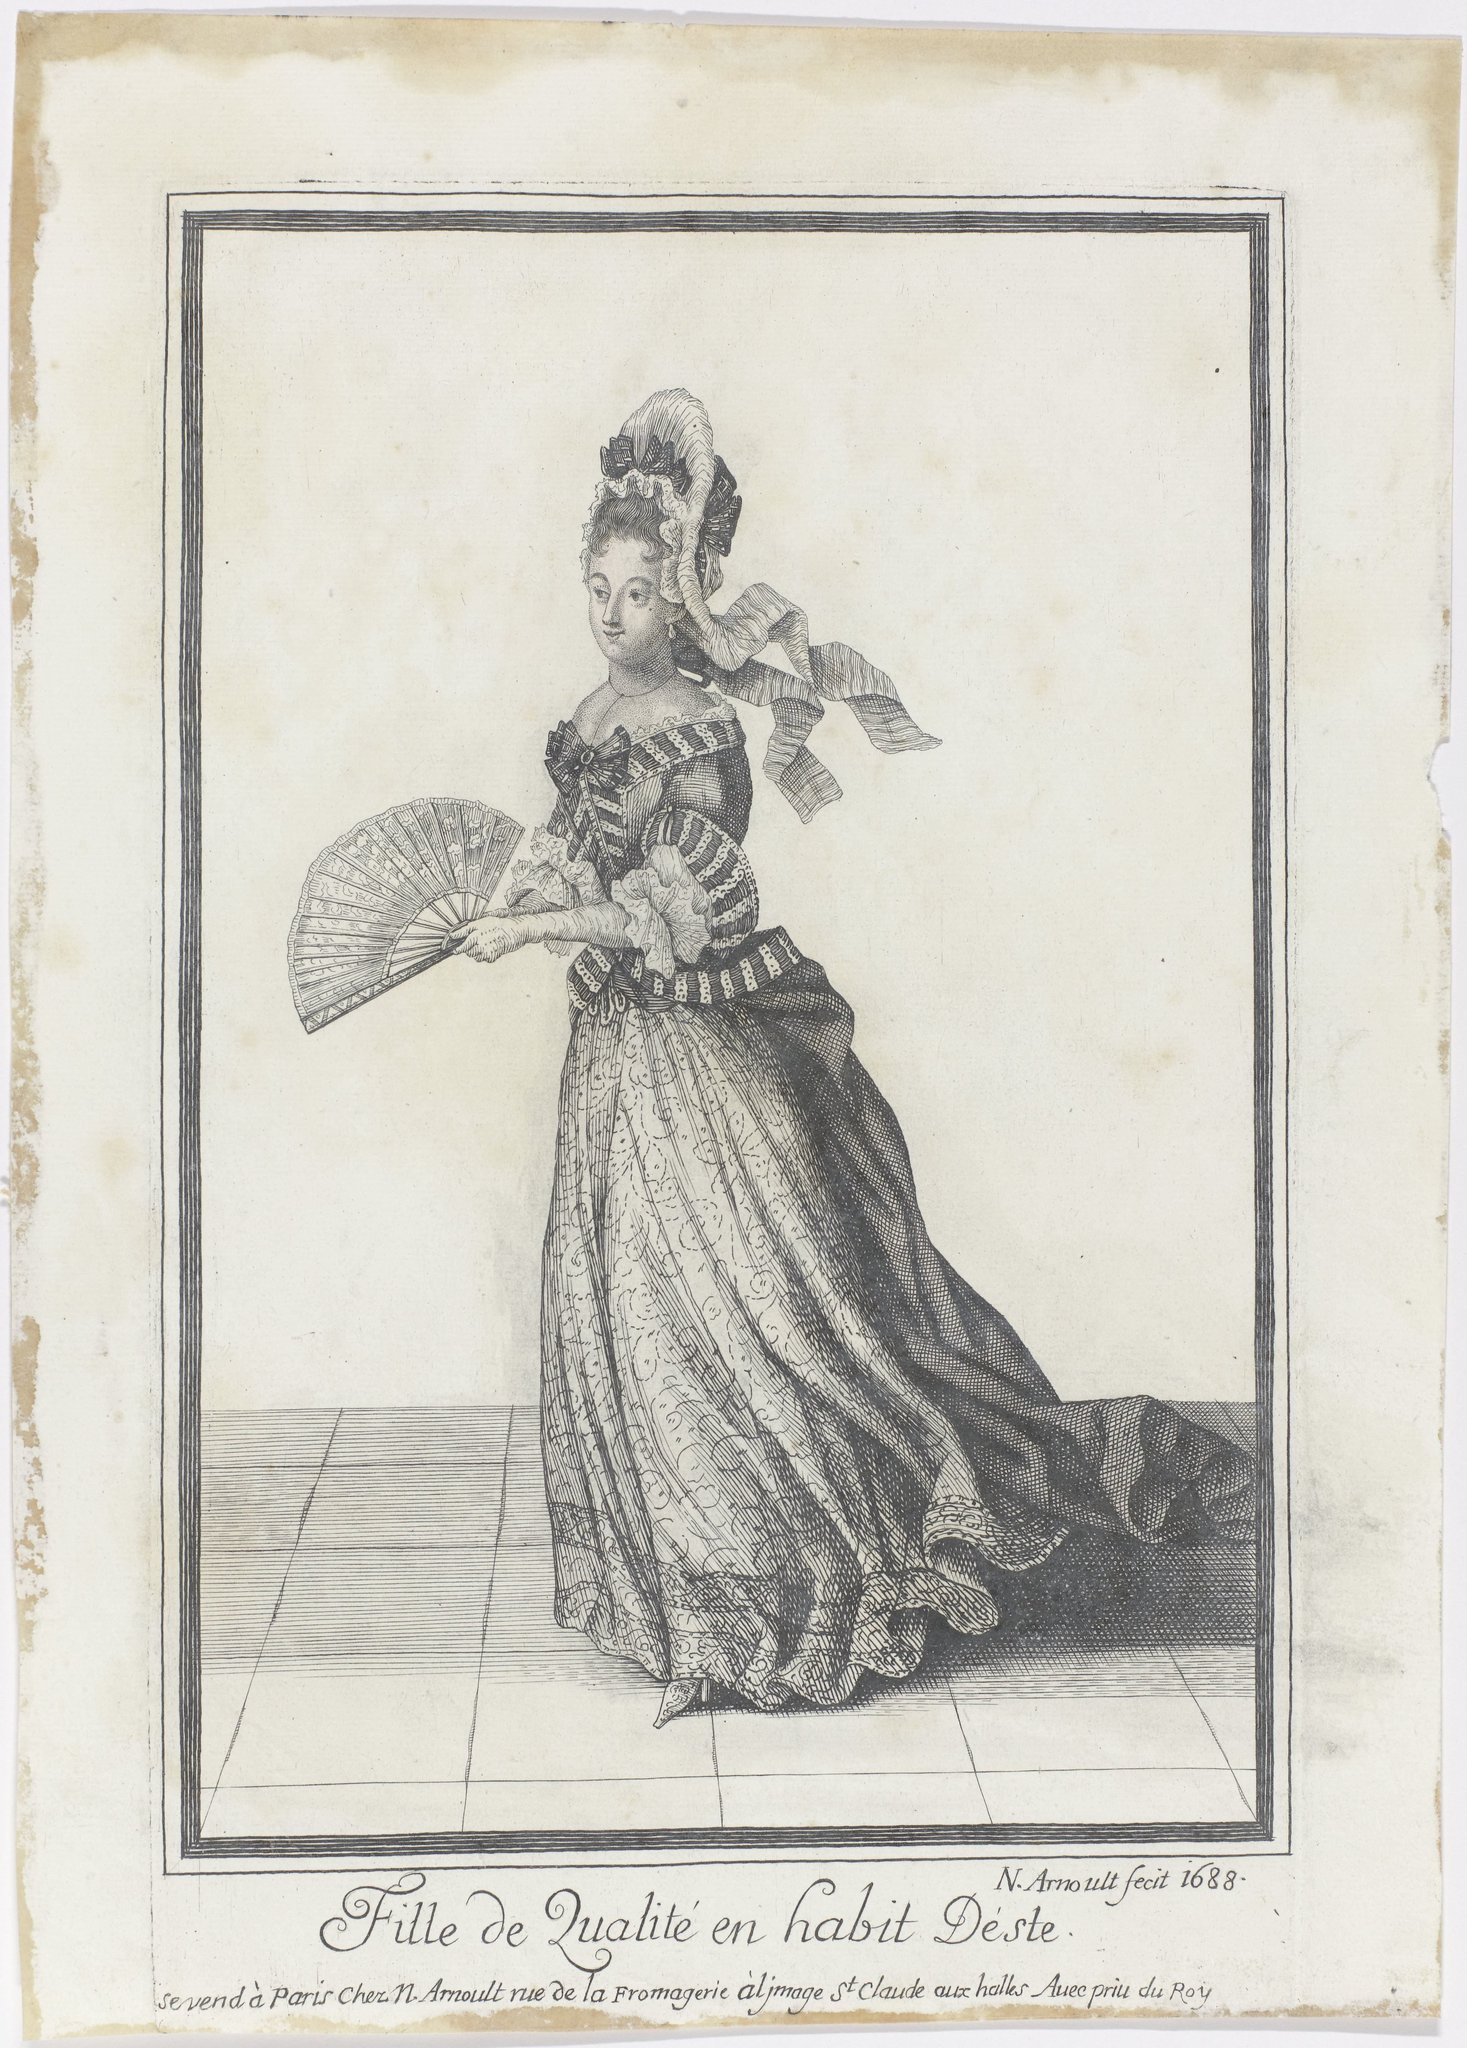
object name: costume print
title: Fille de Qualité en habit d'Esté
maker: nicolas arnoult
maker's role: print maker, publisher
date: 1688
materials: paper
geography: paris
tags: head-gear: cap (+ women's clothes), fashion plates, dress, gown: manteau (+ women's clothes), clothing for the upper part of the body (with name) (+ women's clothes)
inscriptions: date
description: Jonge vrouw van stand, naar links, gekleed in zomerkostuum. Ze draagt een manteau met engageantes, waarvan het lijfje is afgezet met een rand van gestreepte stof. De rok in een sleep. Op het hoofd een muts versierd met strikjes en afhangende slippen. Opengeklapte vouwwaaier in de hand.